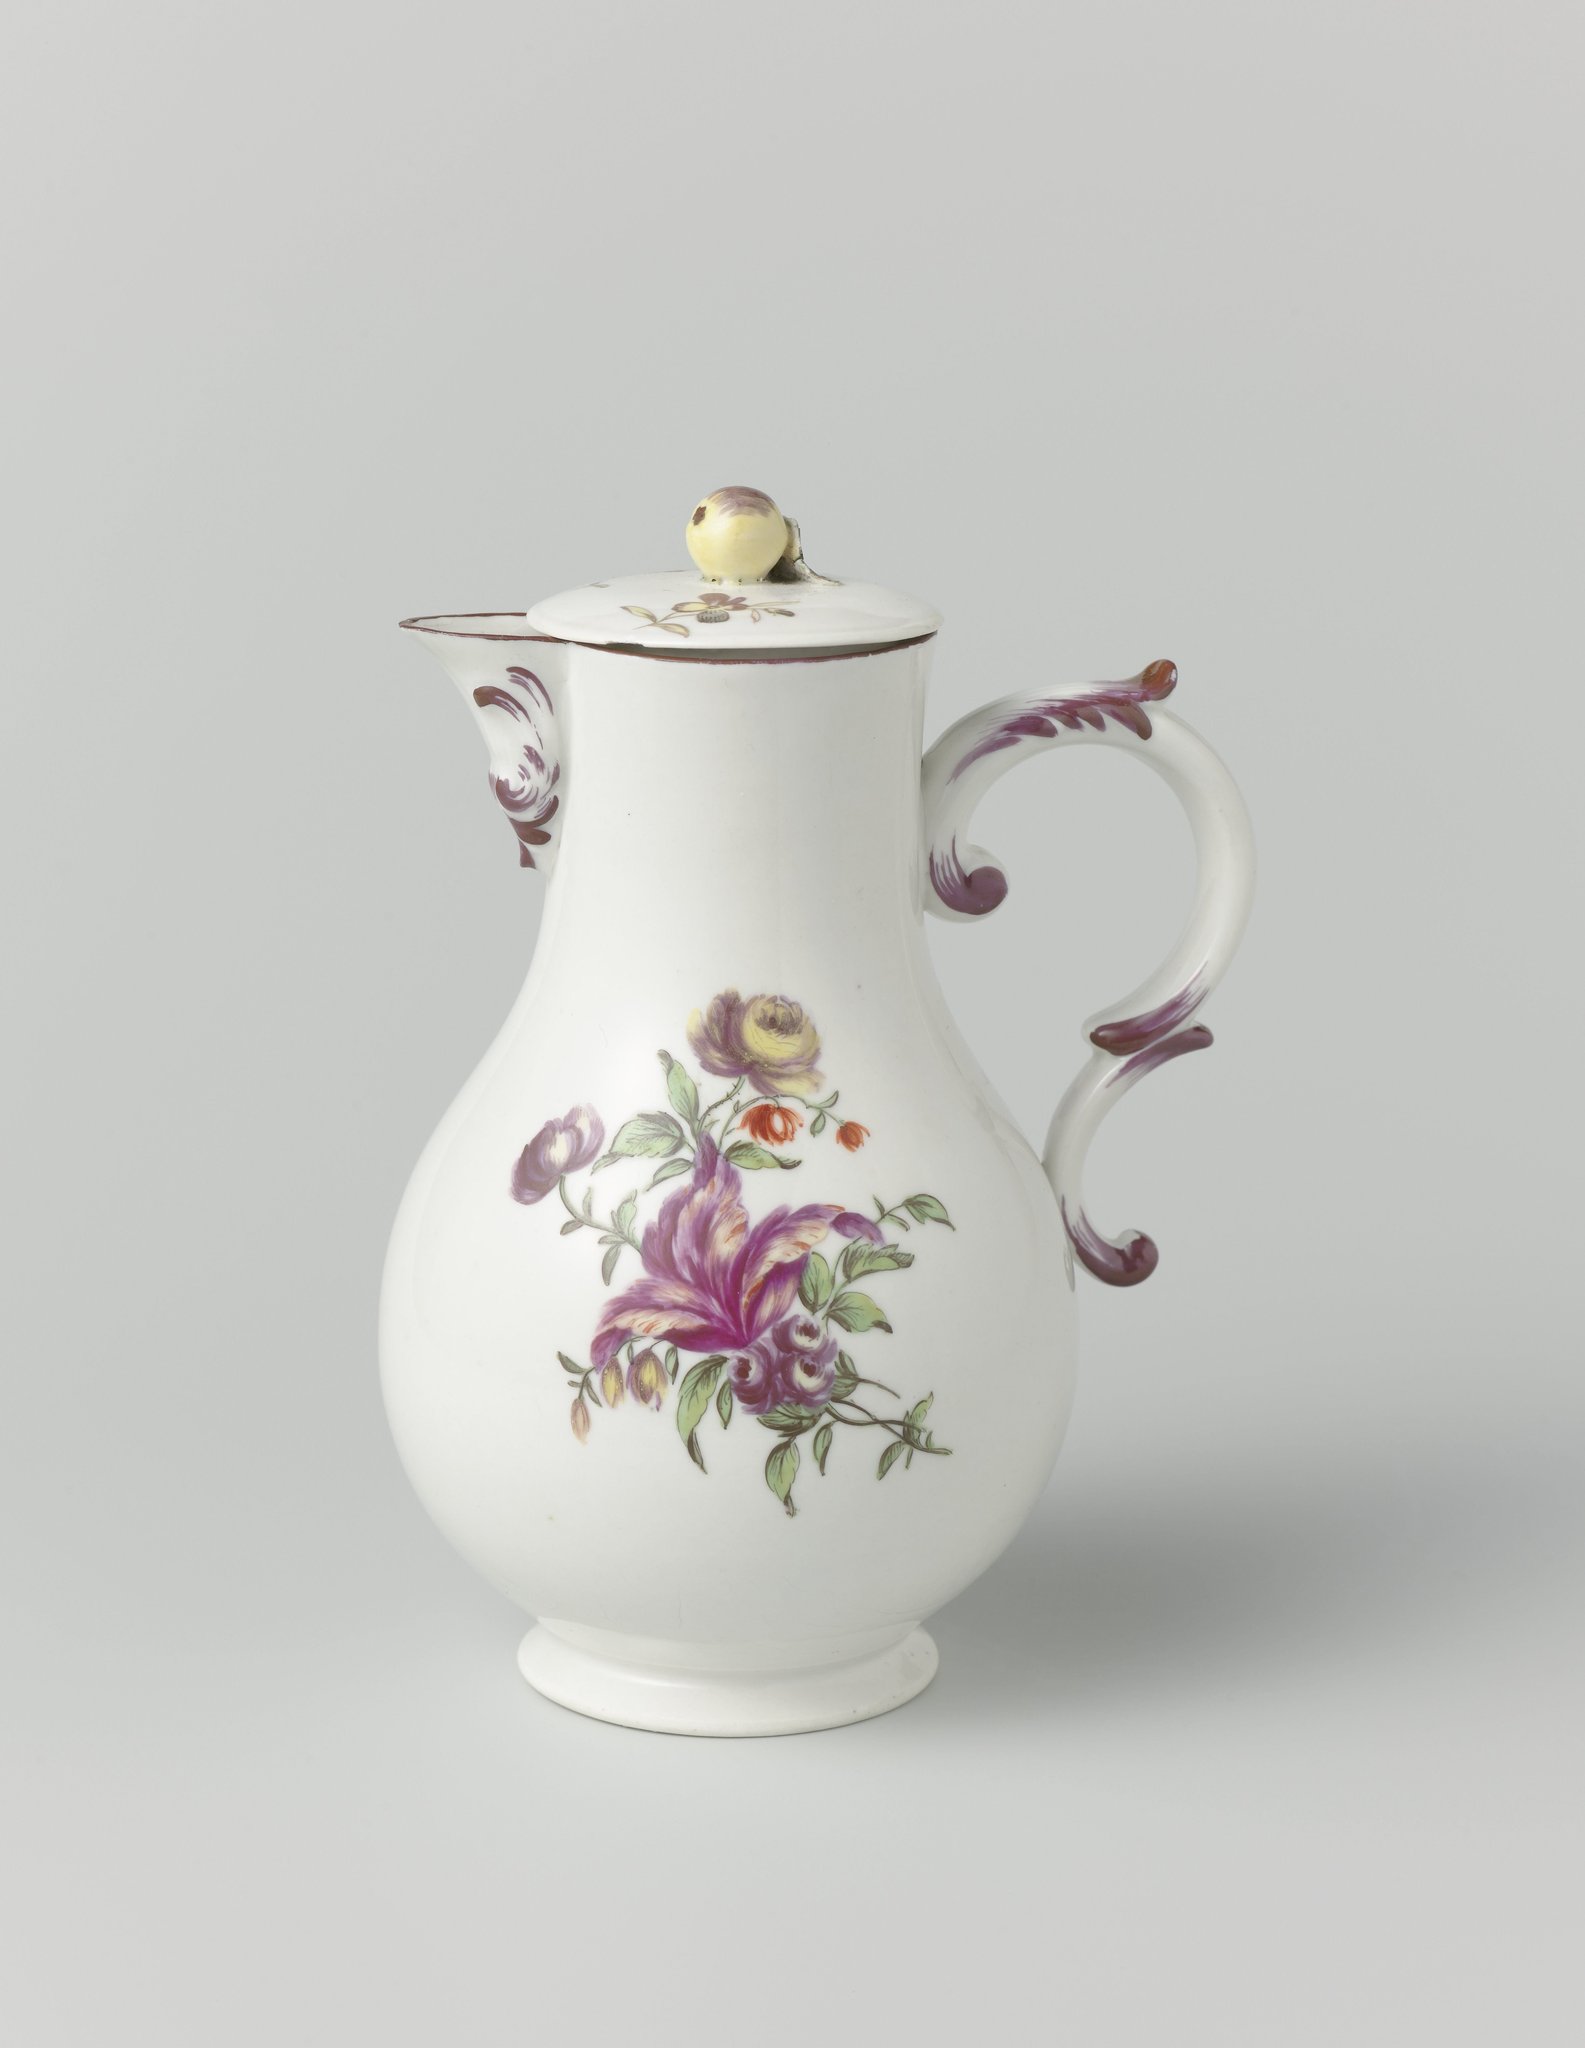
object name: milk jug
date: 1759-1771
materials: porcelain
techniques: painted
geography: weesp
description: Weesper porseleinfabriek Weesp, c. 1759–1771 hard-paste porcelain